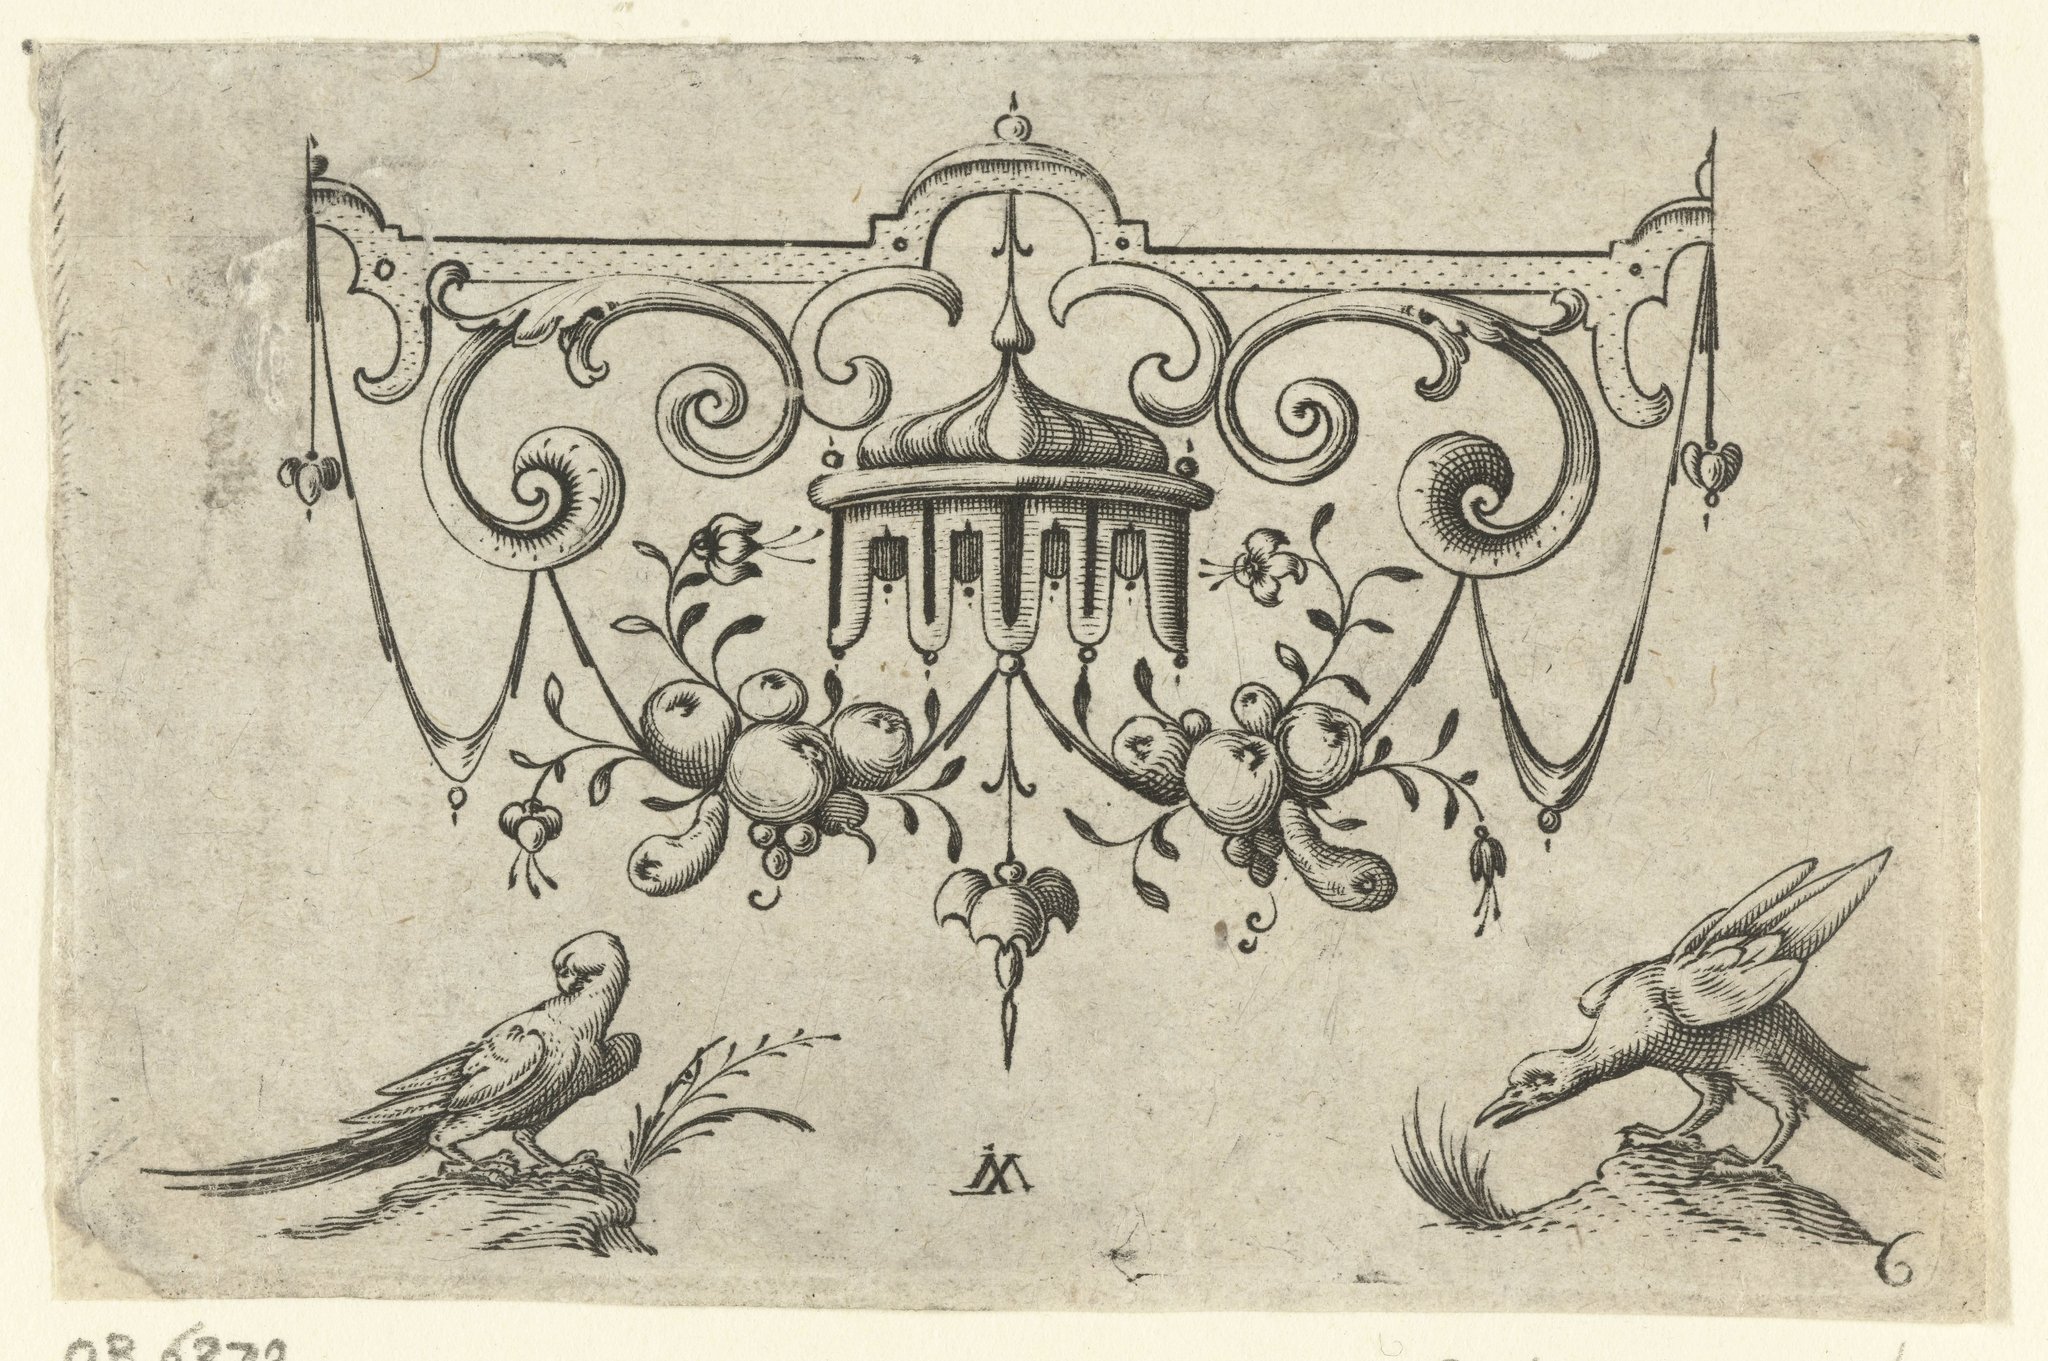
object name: ornament print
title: Spitsen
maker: adriaen muntinck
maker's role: print maker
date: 1611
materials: paper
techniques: engraving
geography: groningen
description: Linksonder en rechtsonder zit een vogel.